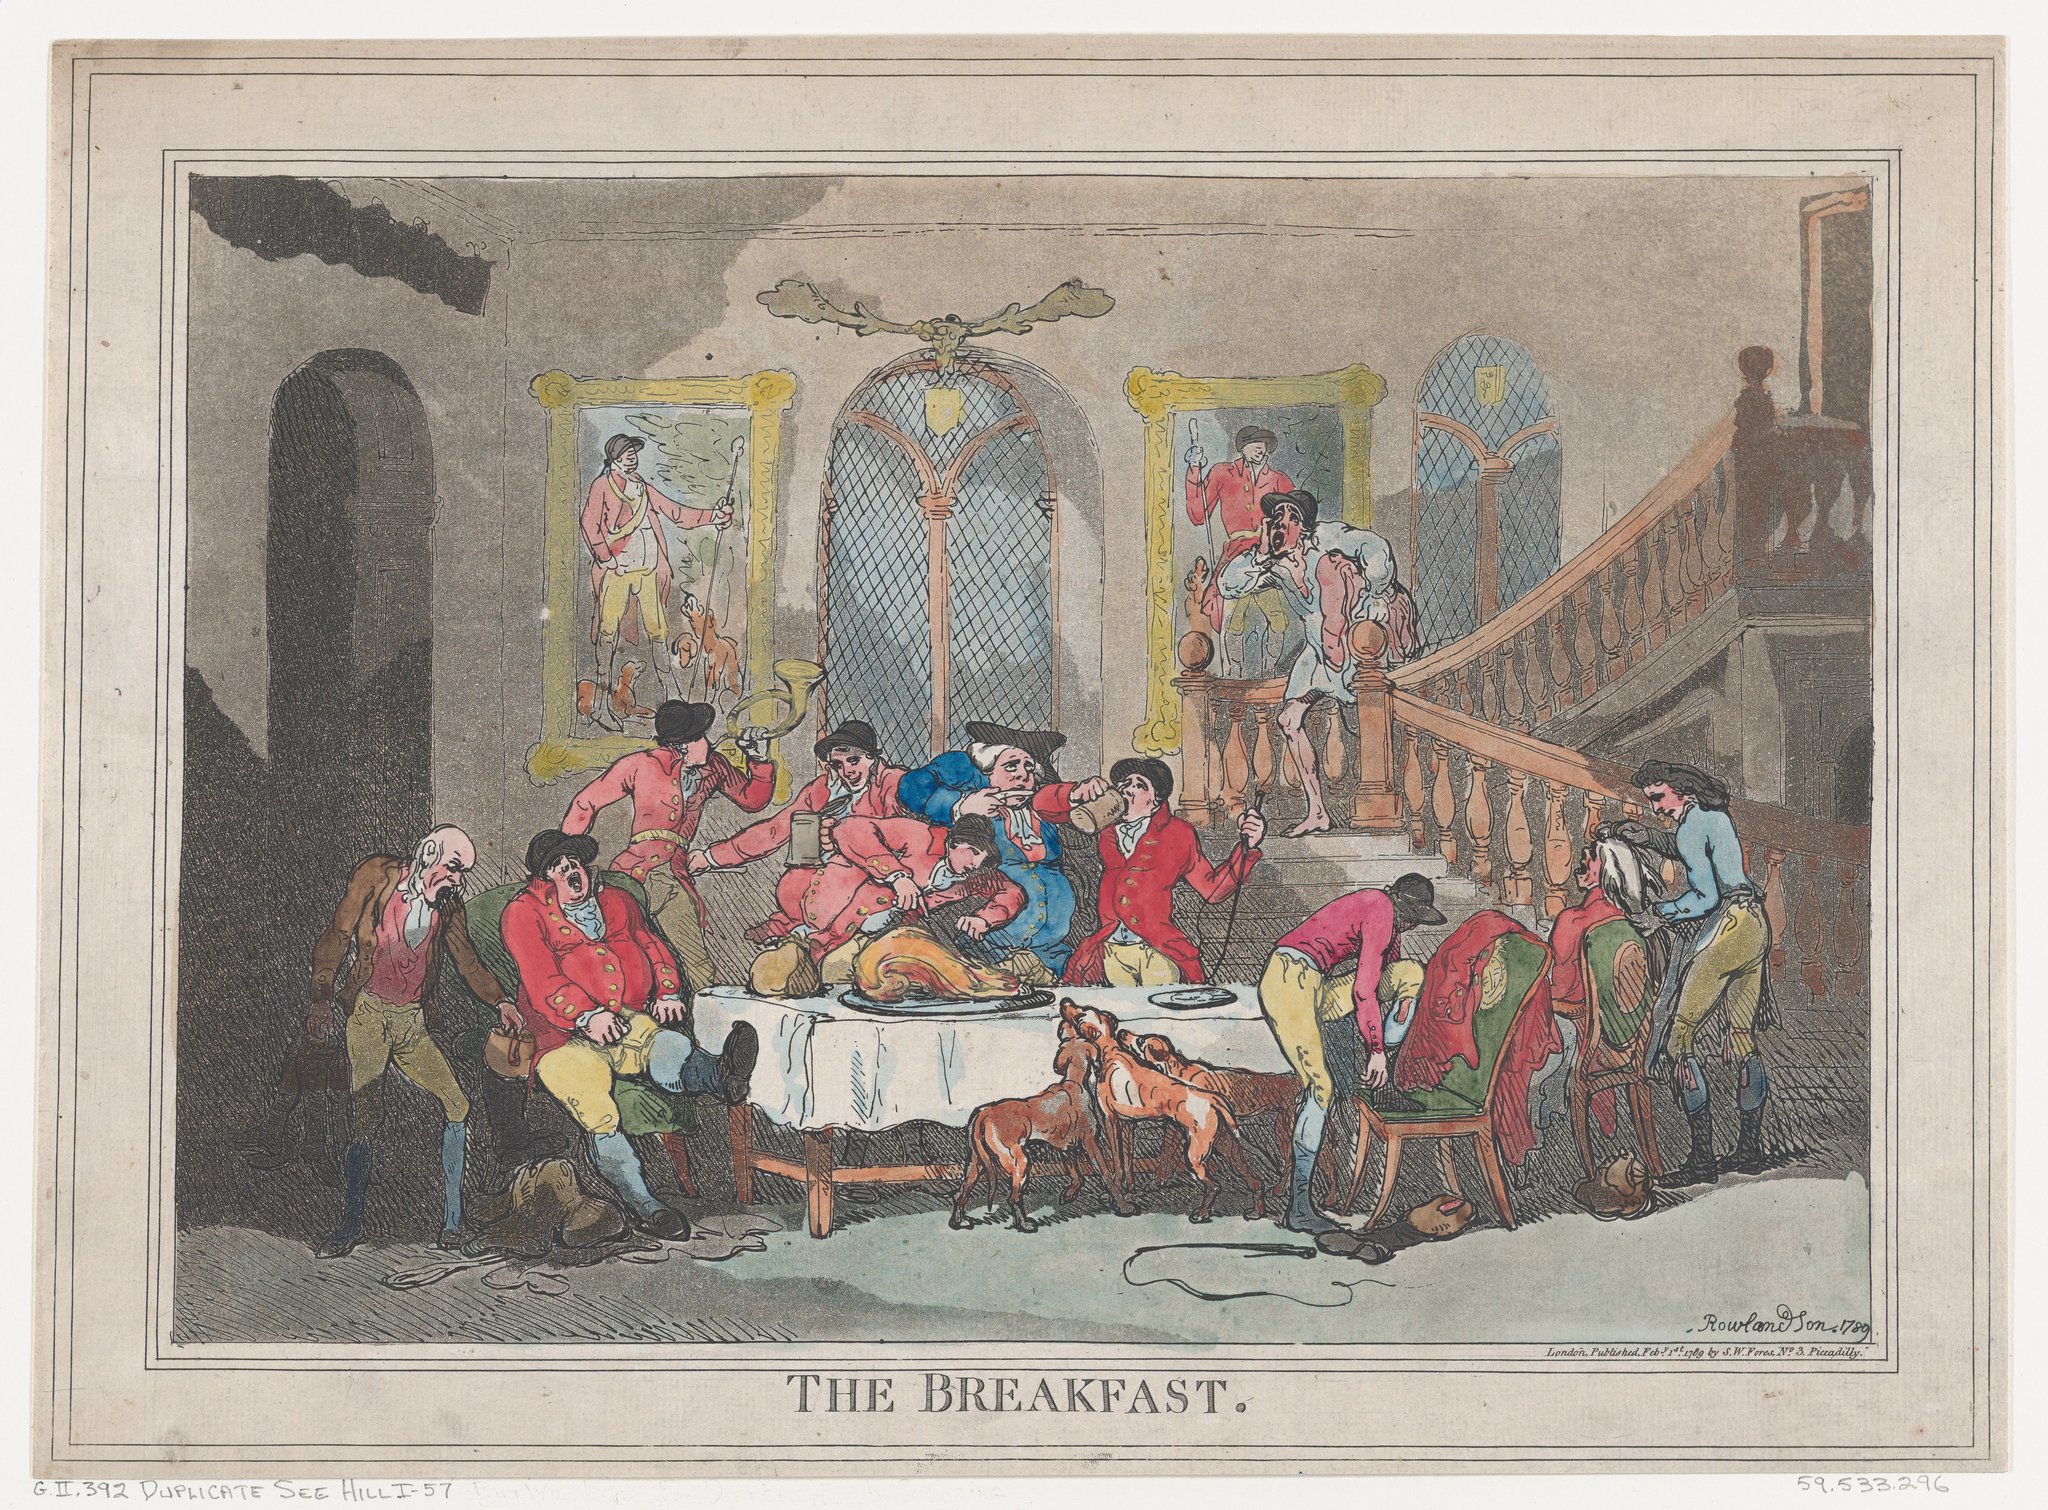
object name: print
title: The Breakfast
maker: thomas rowlandson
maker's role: artist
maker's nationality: british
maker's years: 1757-1827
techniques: aquatint, etching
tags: food,satire,men,dogs,dining,drinking